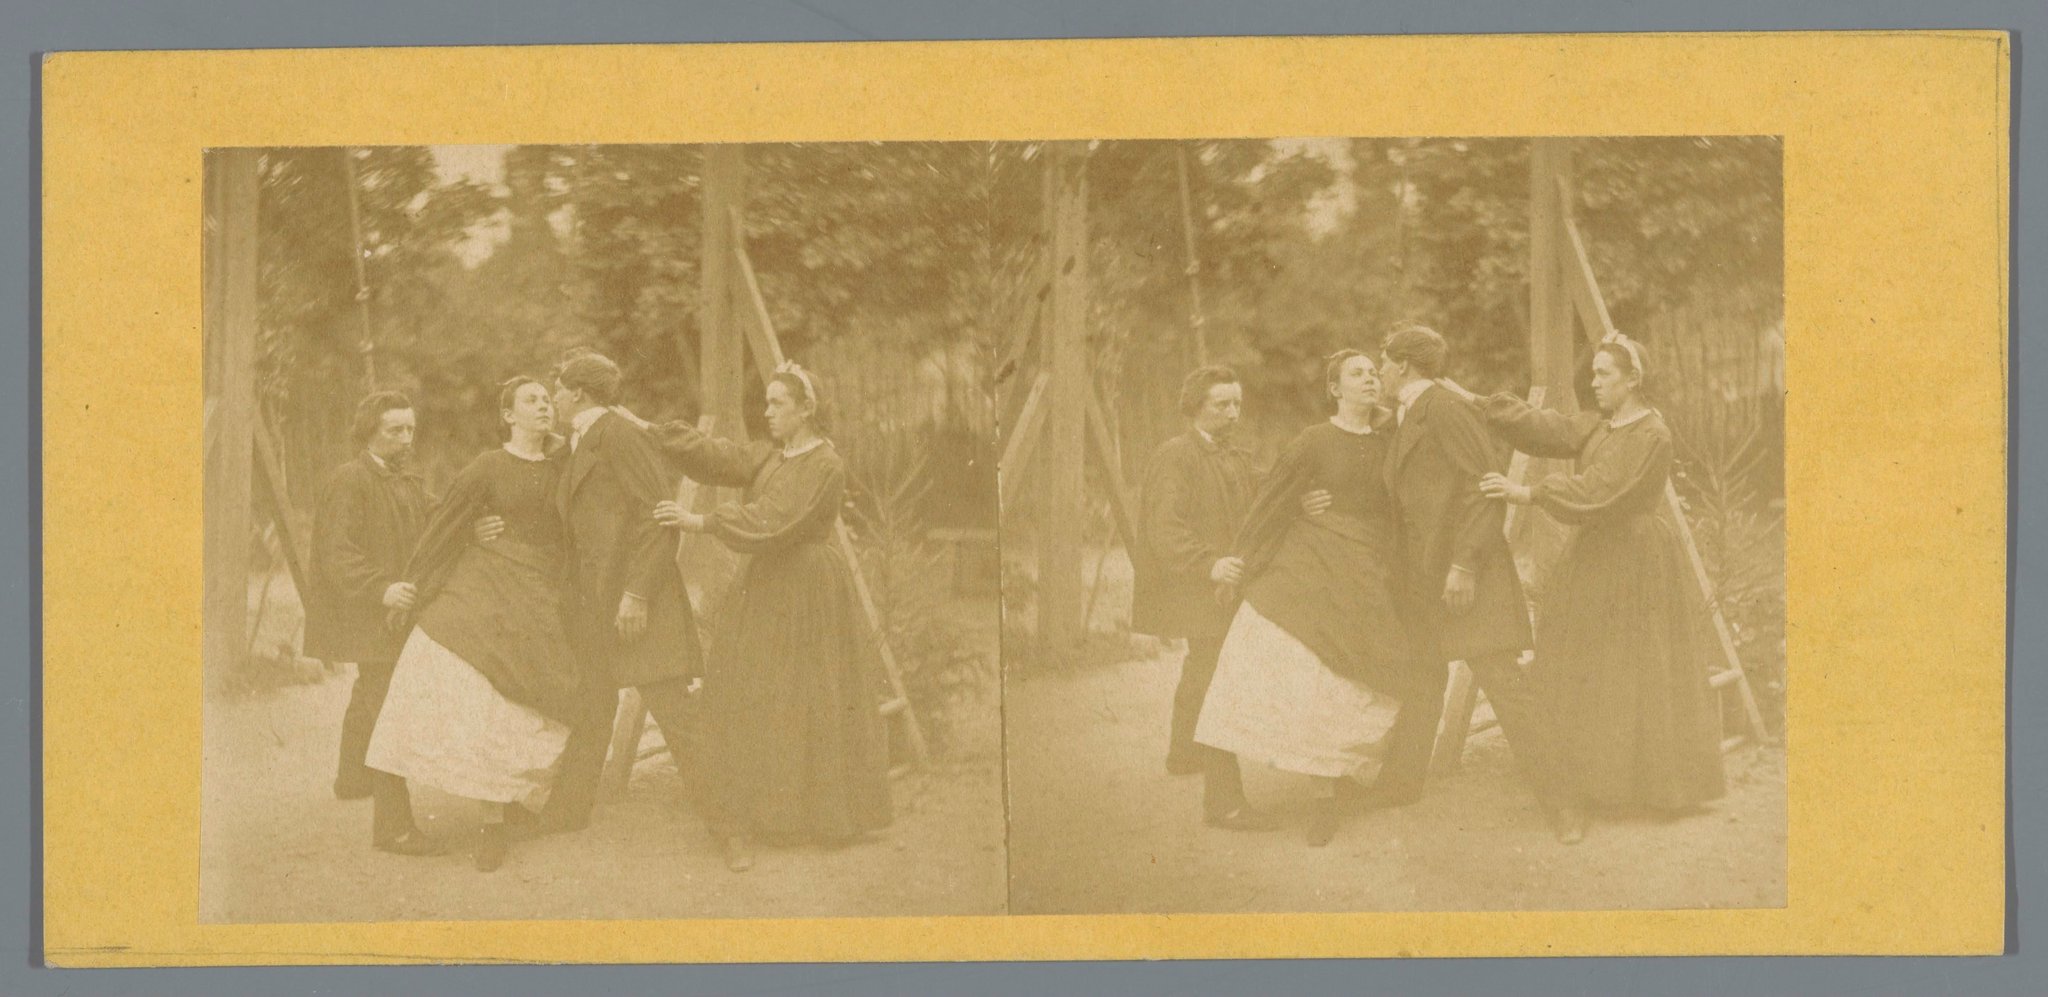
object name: stereograph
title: Vrijend paar wordt door wederhelften uit elkaar gehaald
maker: Anonymous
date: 1850-1880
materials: cardboard, photographic support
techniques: albumen print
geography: europe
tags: couple of lovers, europe